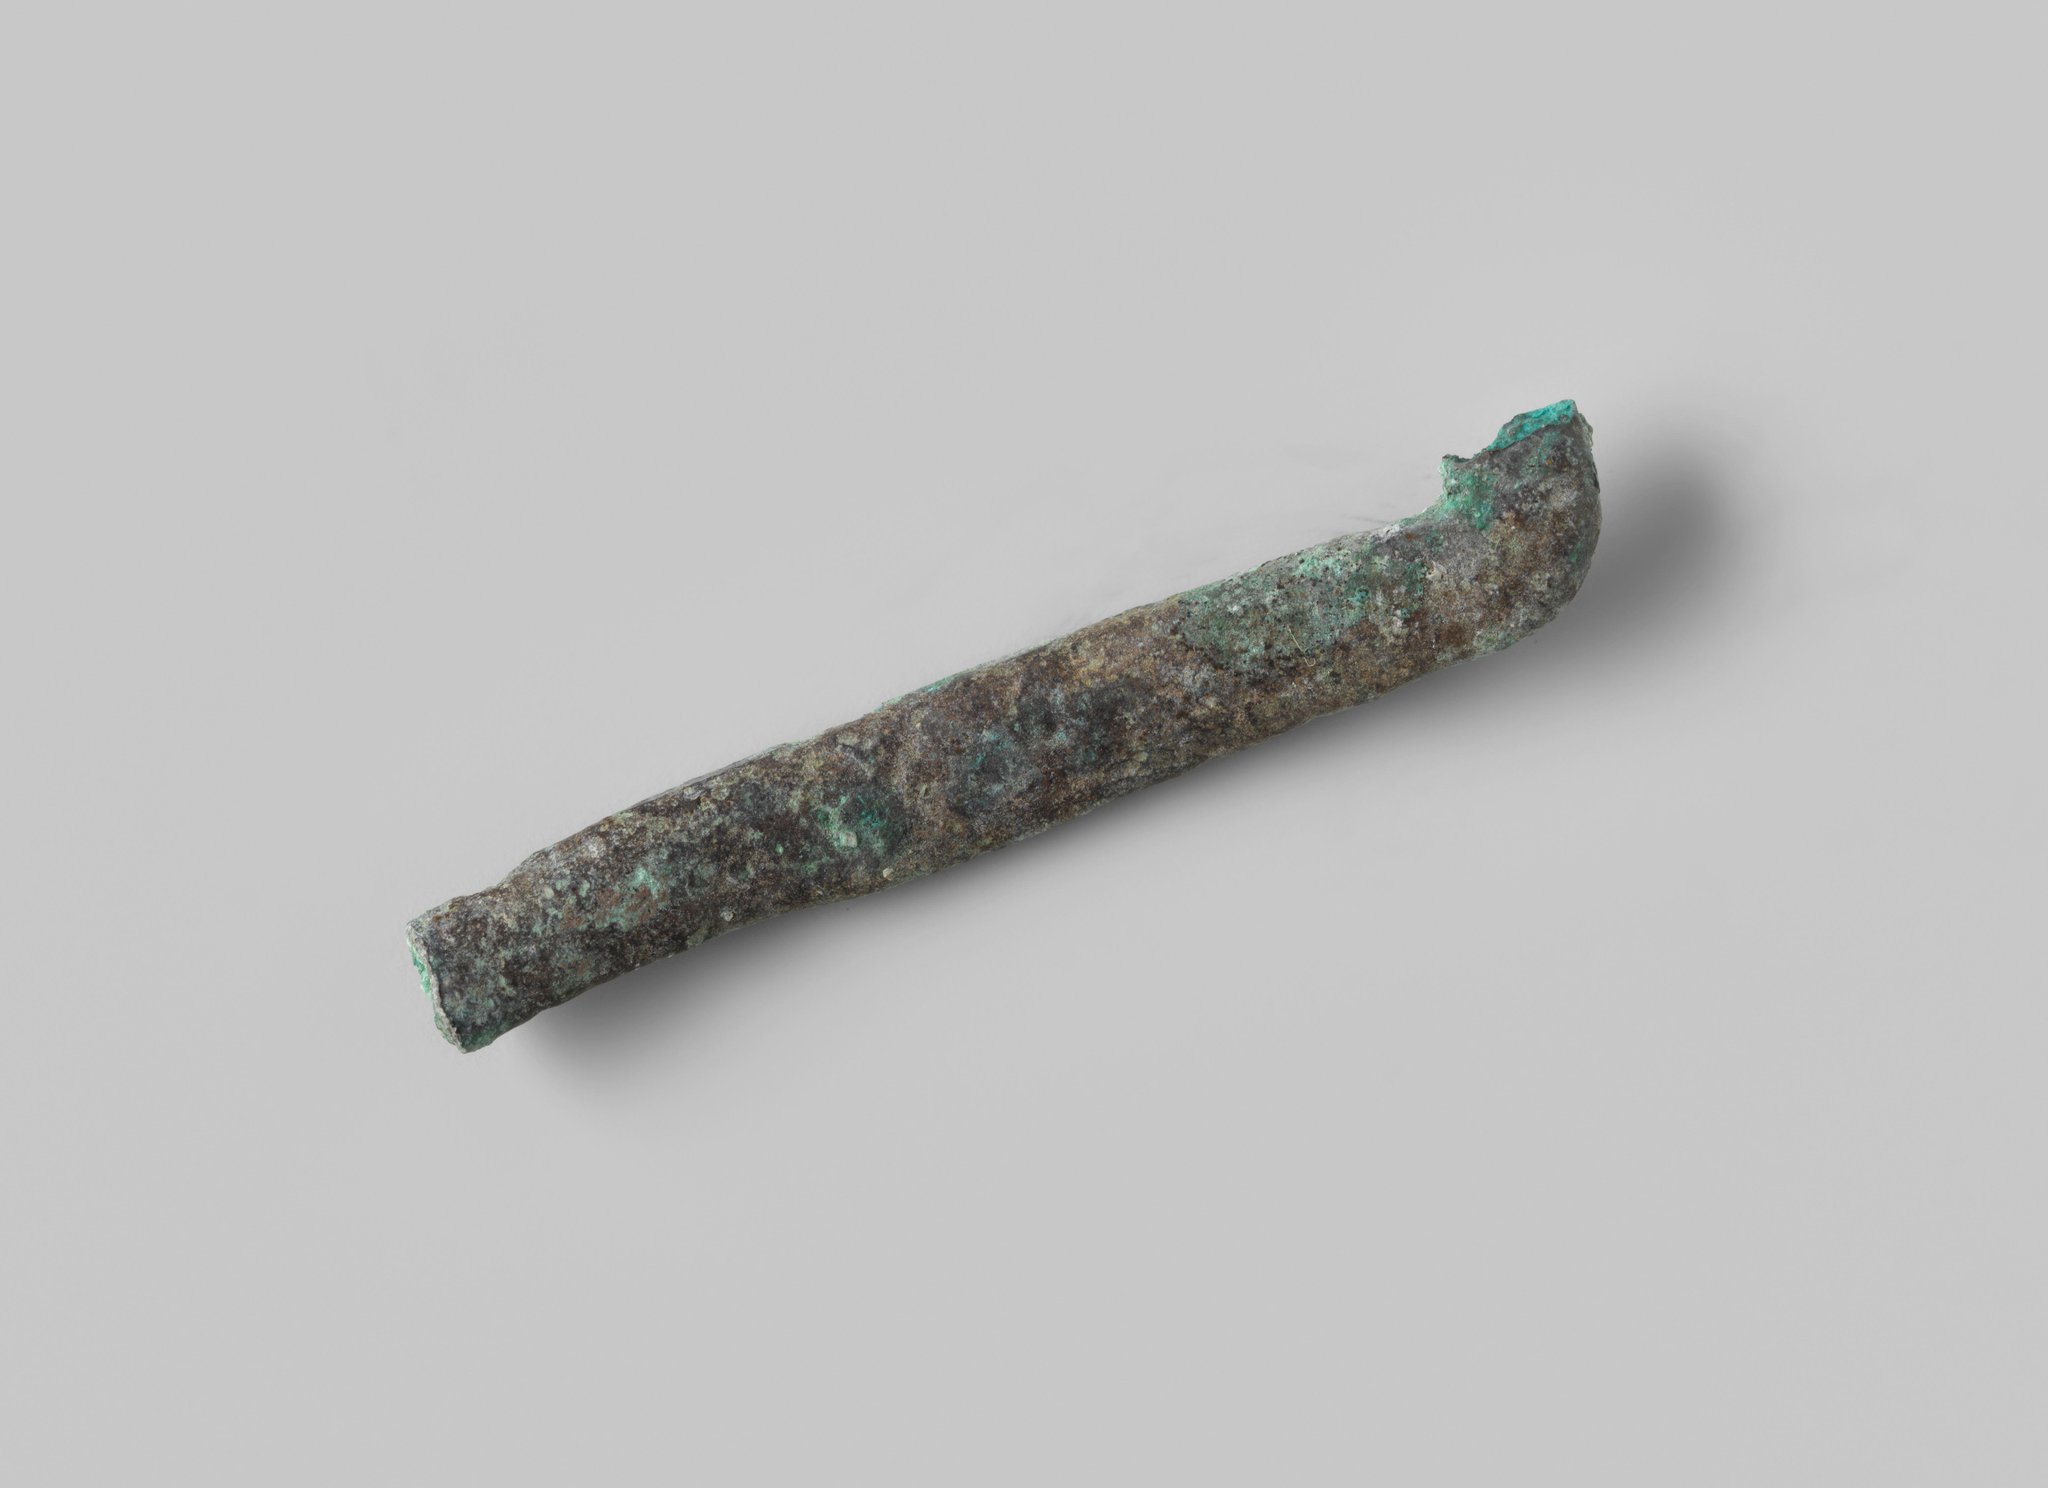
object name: belt buckle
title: Fragment riemgesp uit het wrak van de Oost-Indiëvaarder Hollandia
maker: Anonymous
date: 1700-1743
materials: copper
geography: netherlands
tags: verenigde oostindische compagnie, hollandia (schip), annet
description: Rectangular, fragm of ring, id. NG 1980-27H2796, belt buckle.